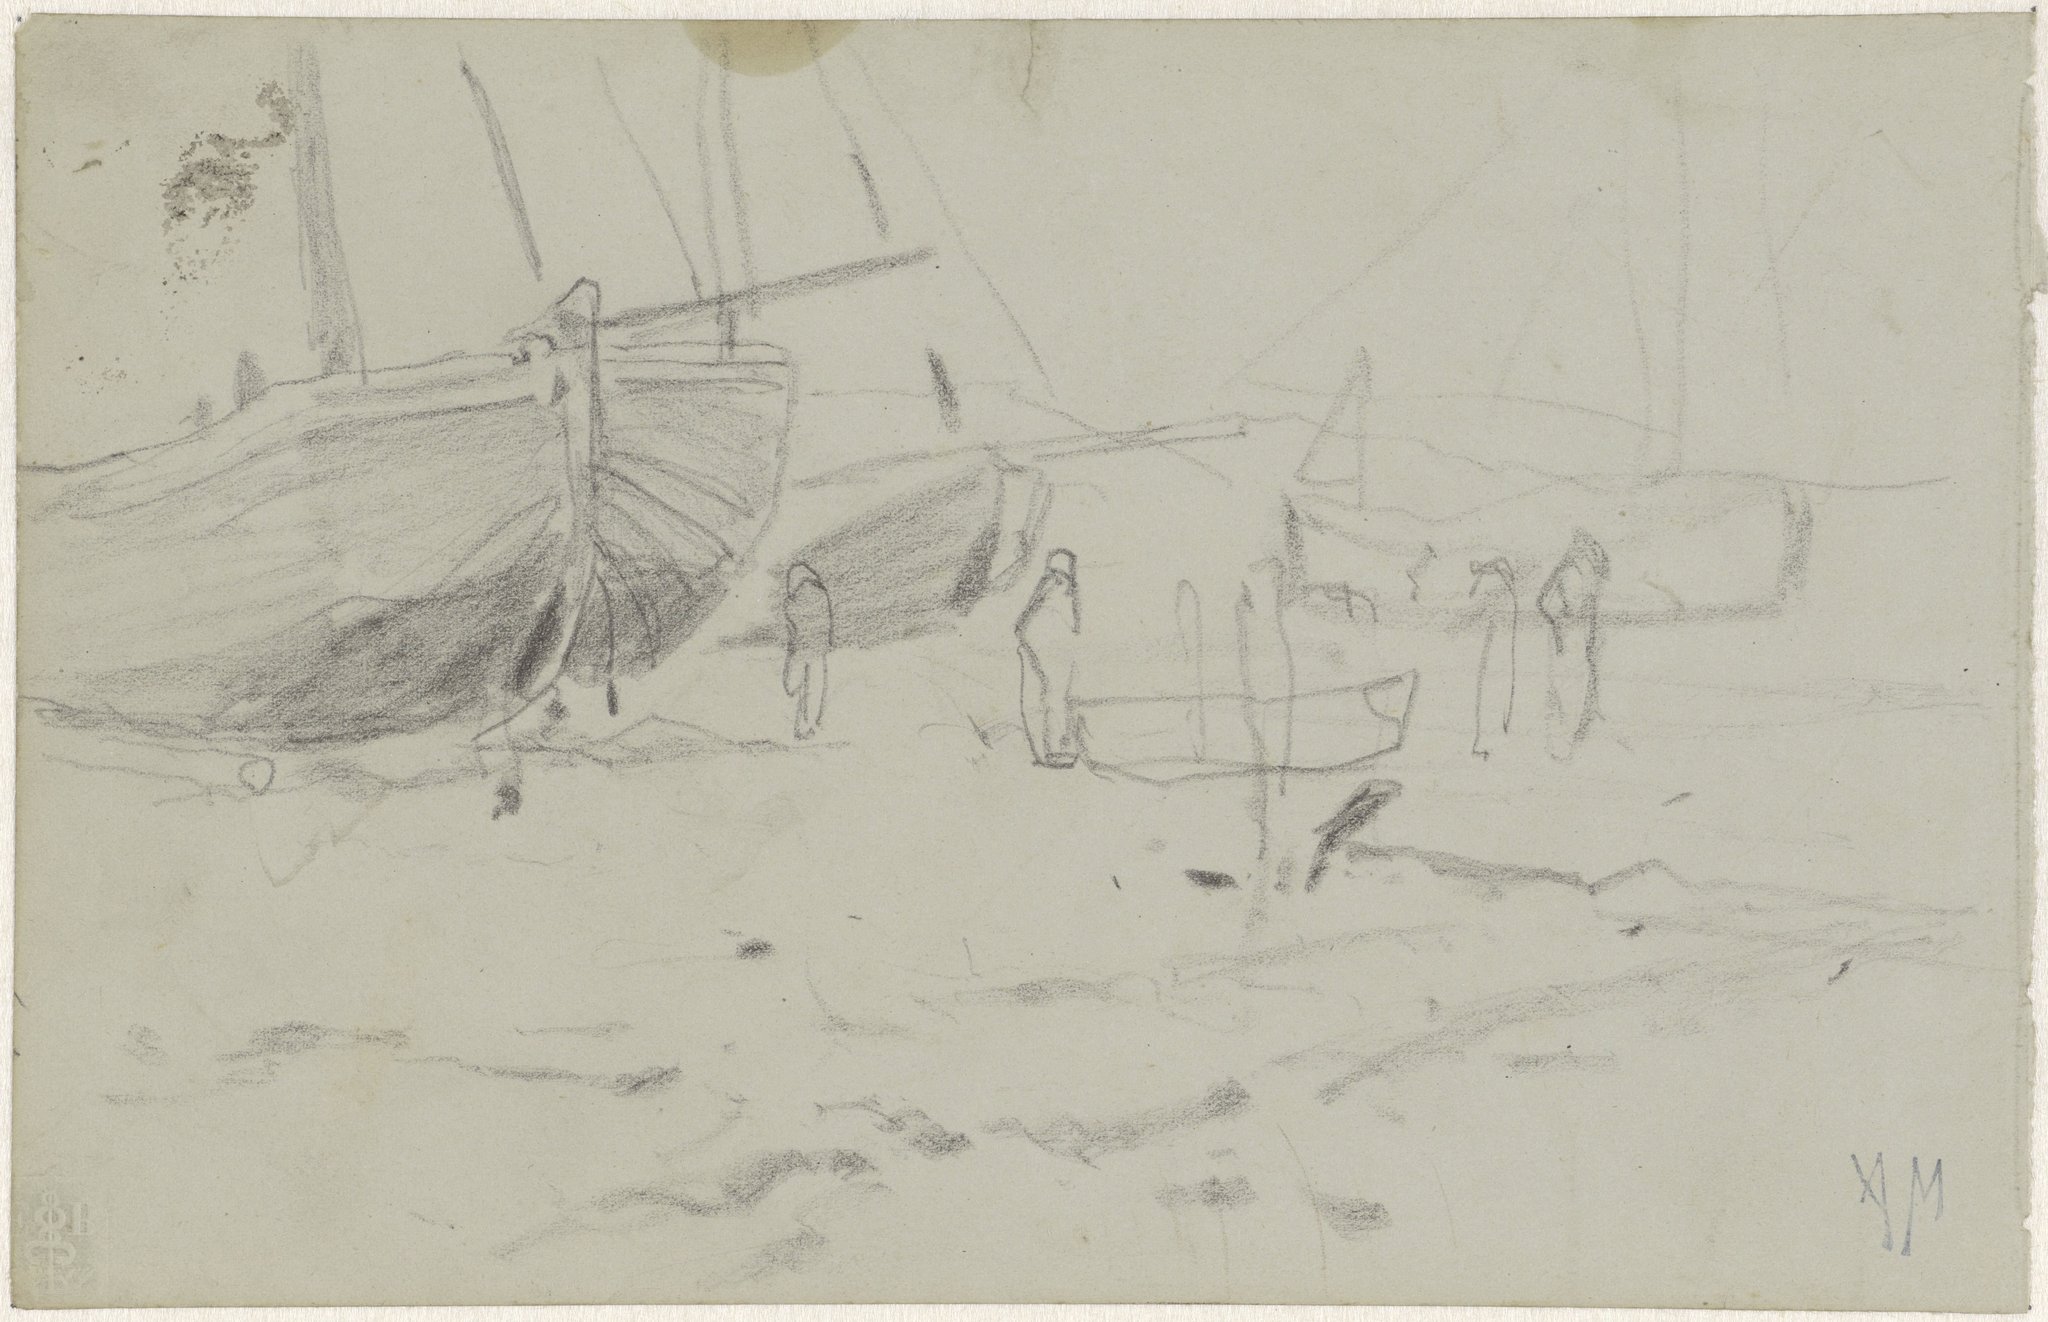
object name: drawing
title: Bomschuiten op het strand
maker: anton mauve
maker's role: draughtsman, painter, print maker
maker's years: 1838-1888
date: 1848-1888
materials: chalk, paper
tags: sailing-ship, sailing-boat, beach